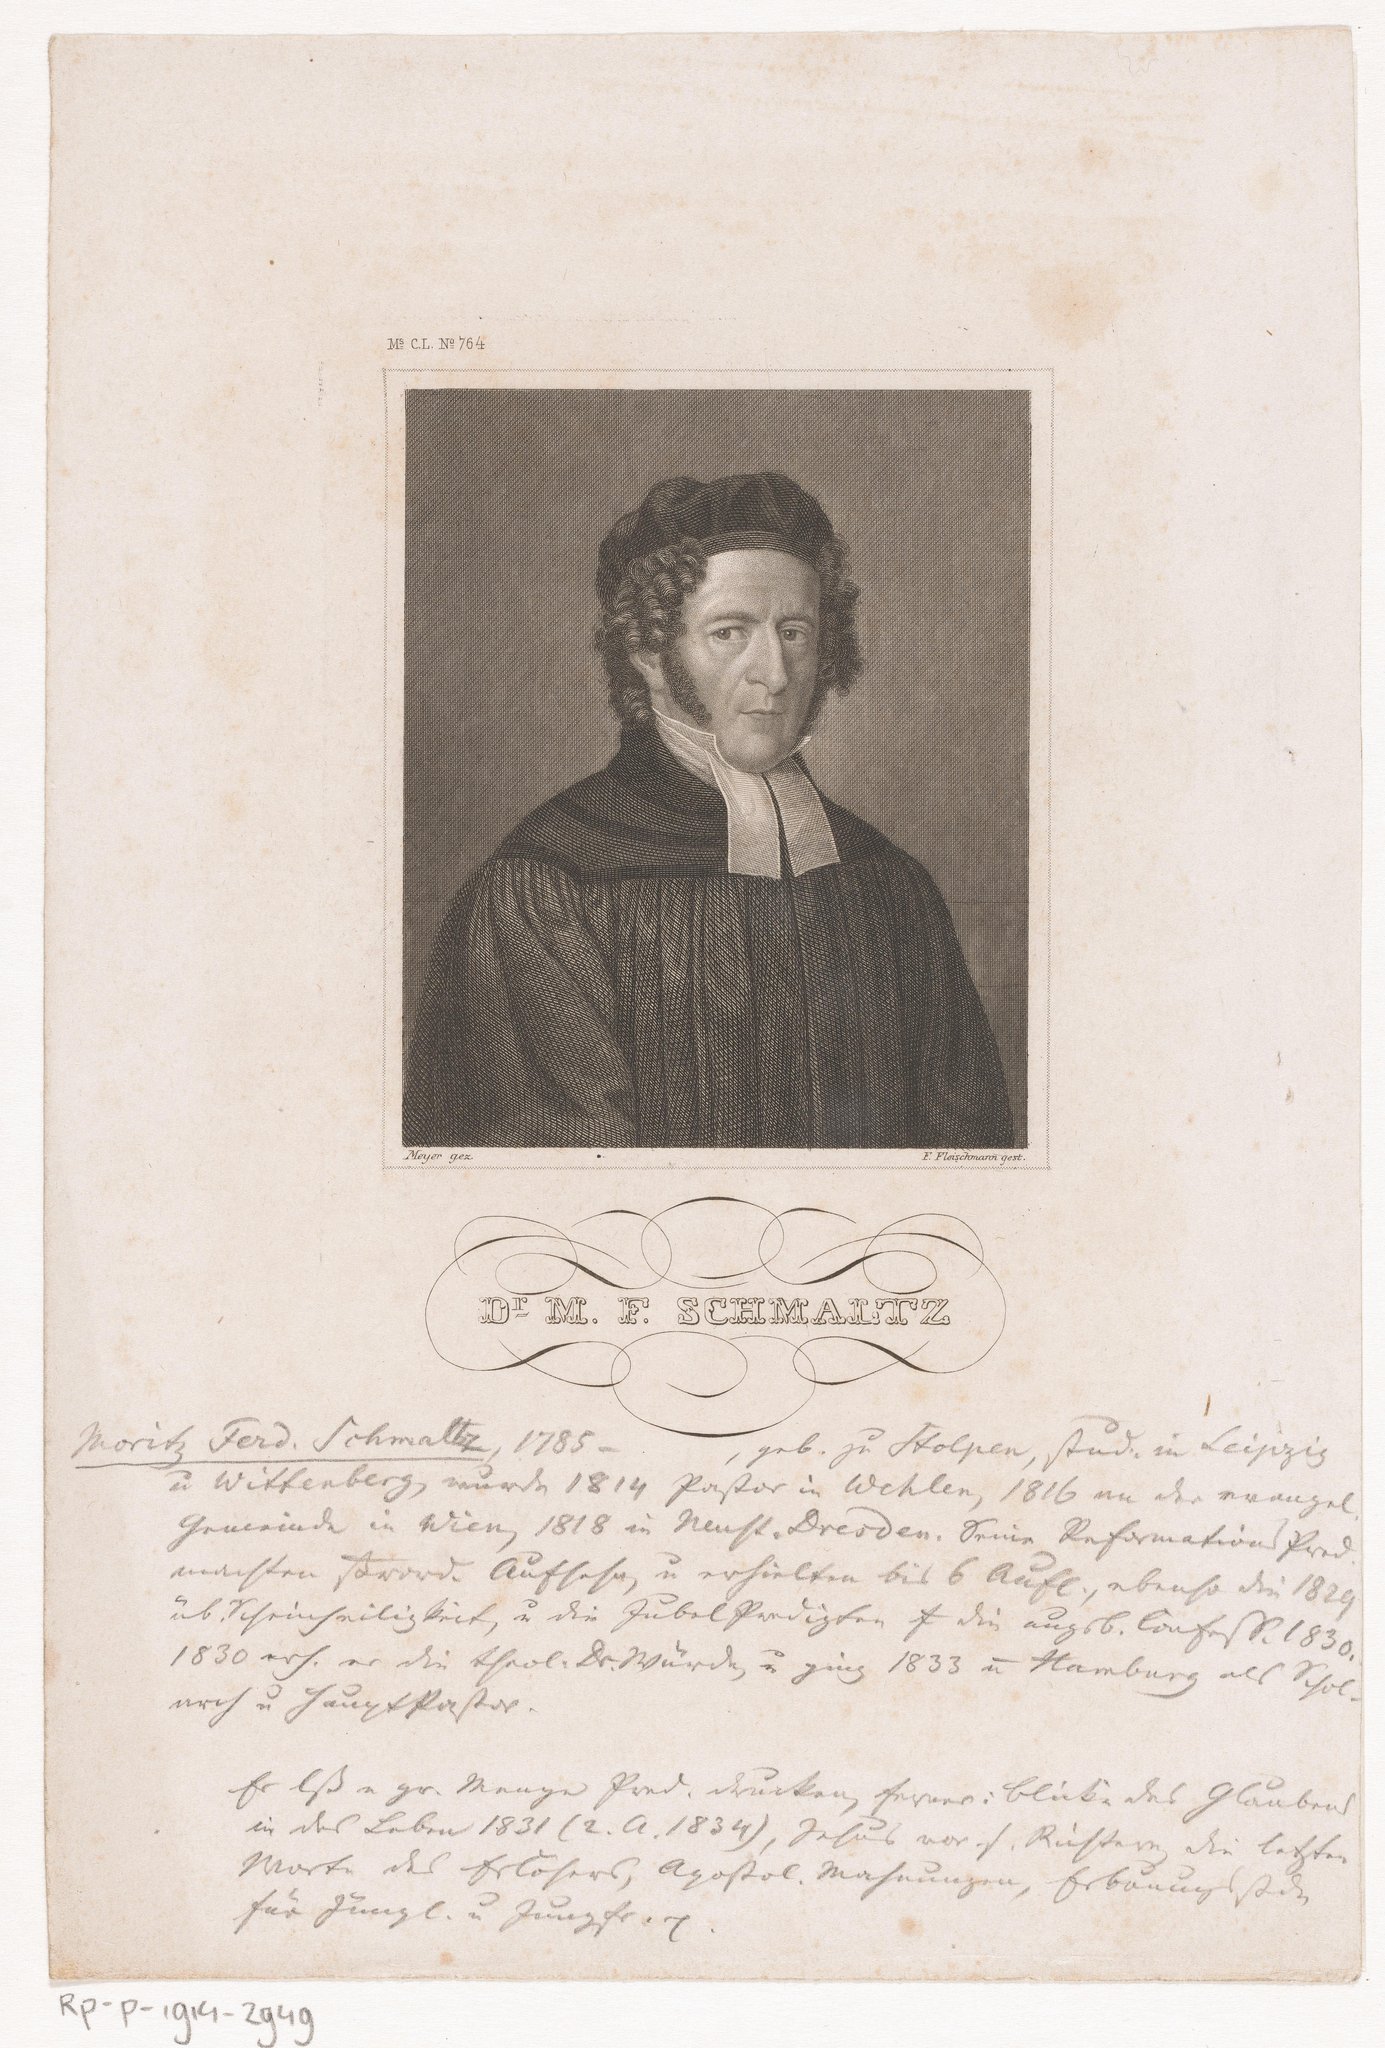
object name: print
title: Portret van Moritz Ferdinand Schmaltz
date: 1840-1855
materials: paper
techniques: calligraphy, engraving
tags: historical persons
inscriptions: collector's mark: Lugt 2228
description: Prent afkomstig uit: Conversations-Lexikon für die gebildeten Stände, voor het eerst uitgegeven tussen 1840-1855. Uitgebreide biografie van de geportretteerde in potlood onder de prent.